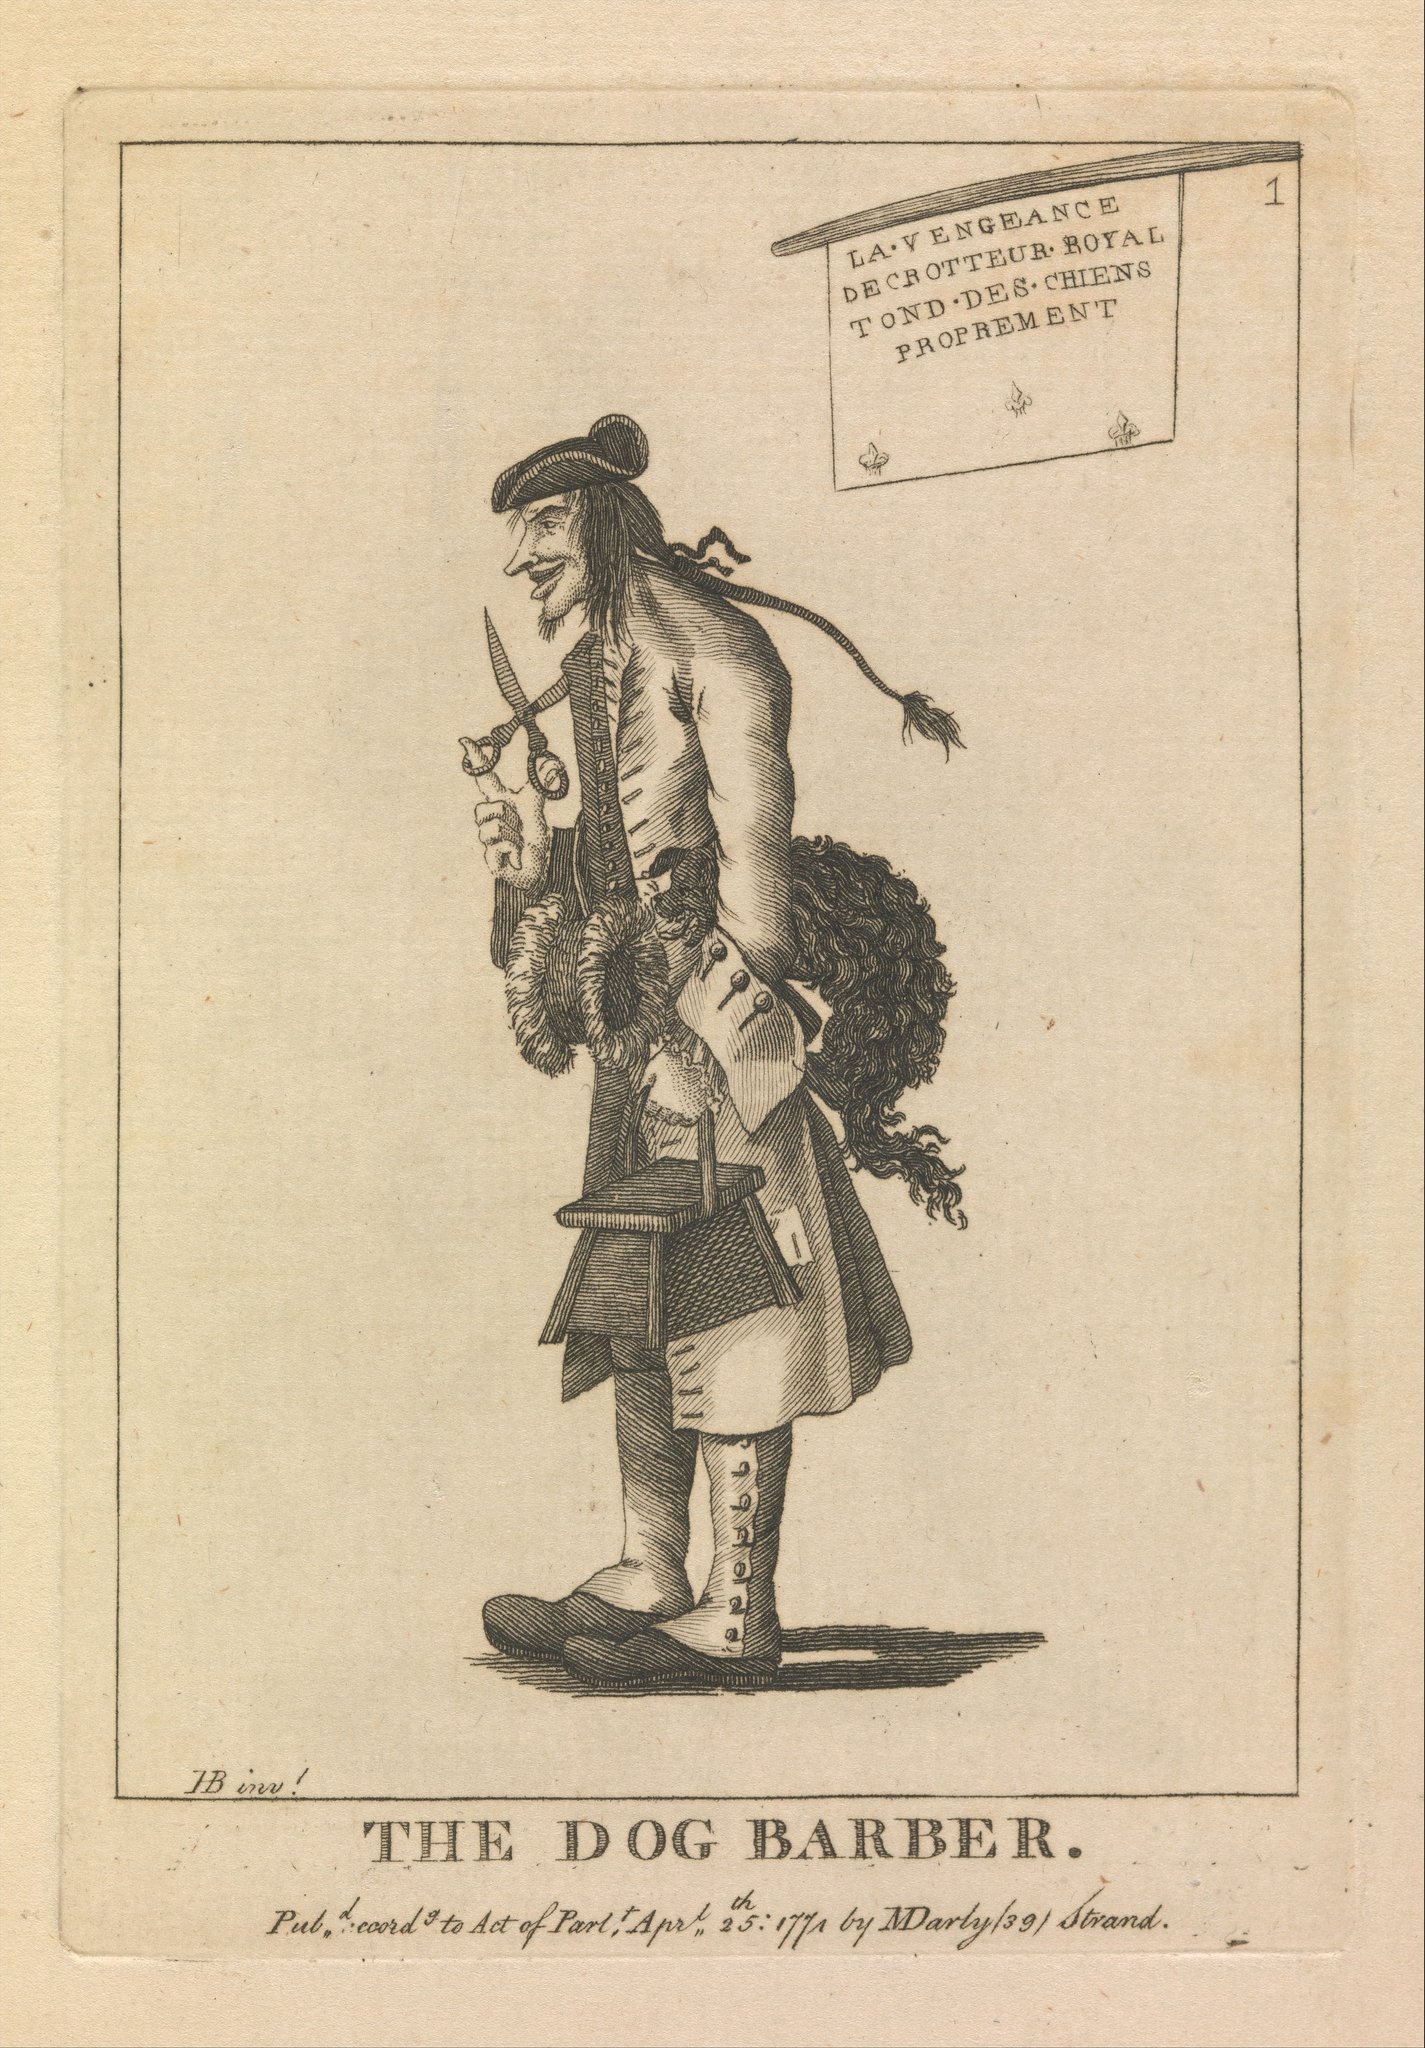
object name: print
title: The Dog Barber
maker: henry william bunbury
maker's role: artist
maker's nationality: british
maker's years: 1750-1811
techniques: etching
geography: london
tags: men,dogs,scissors